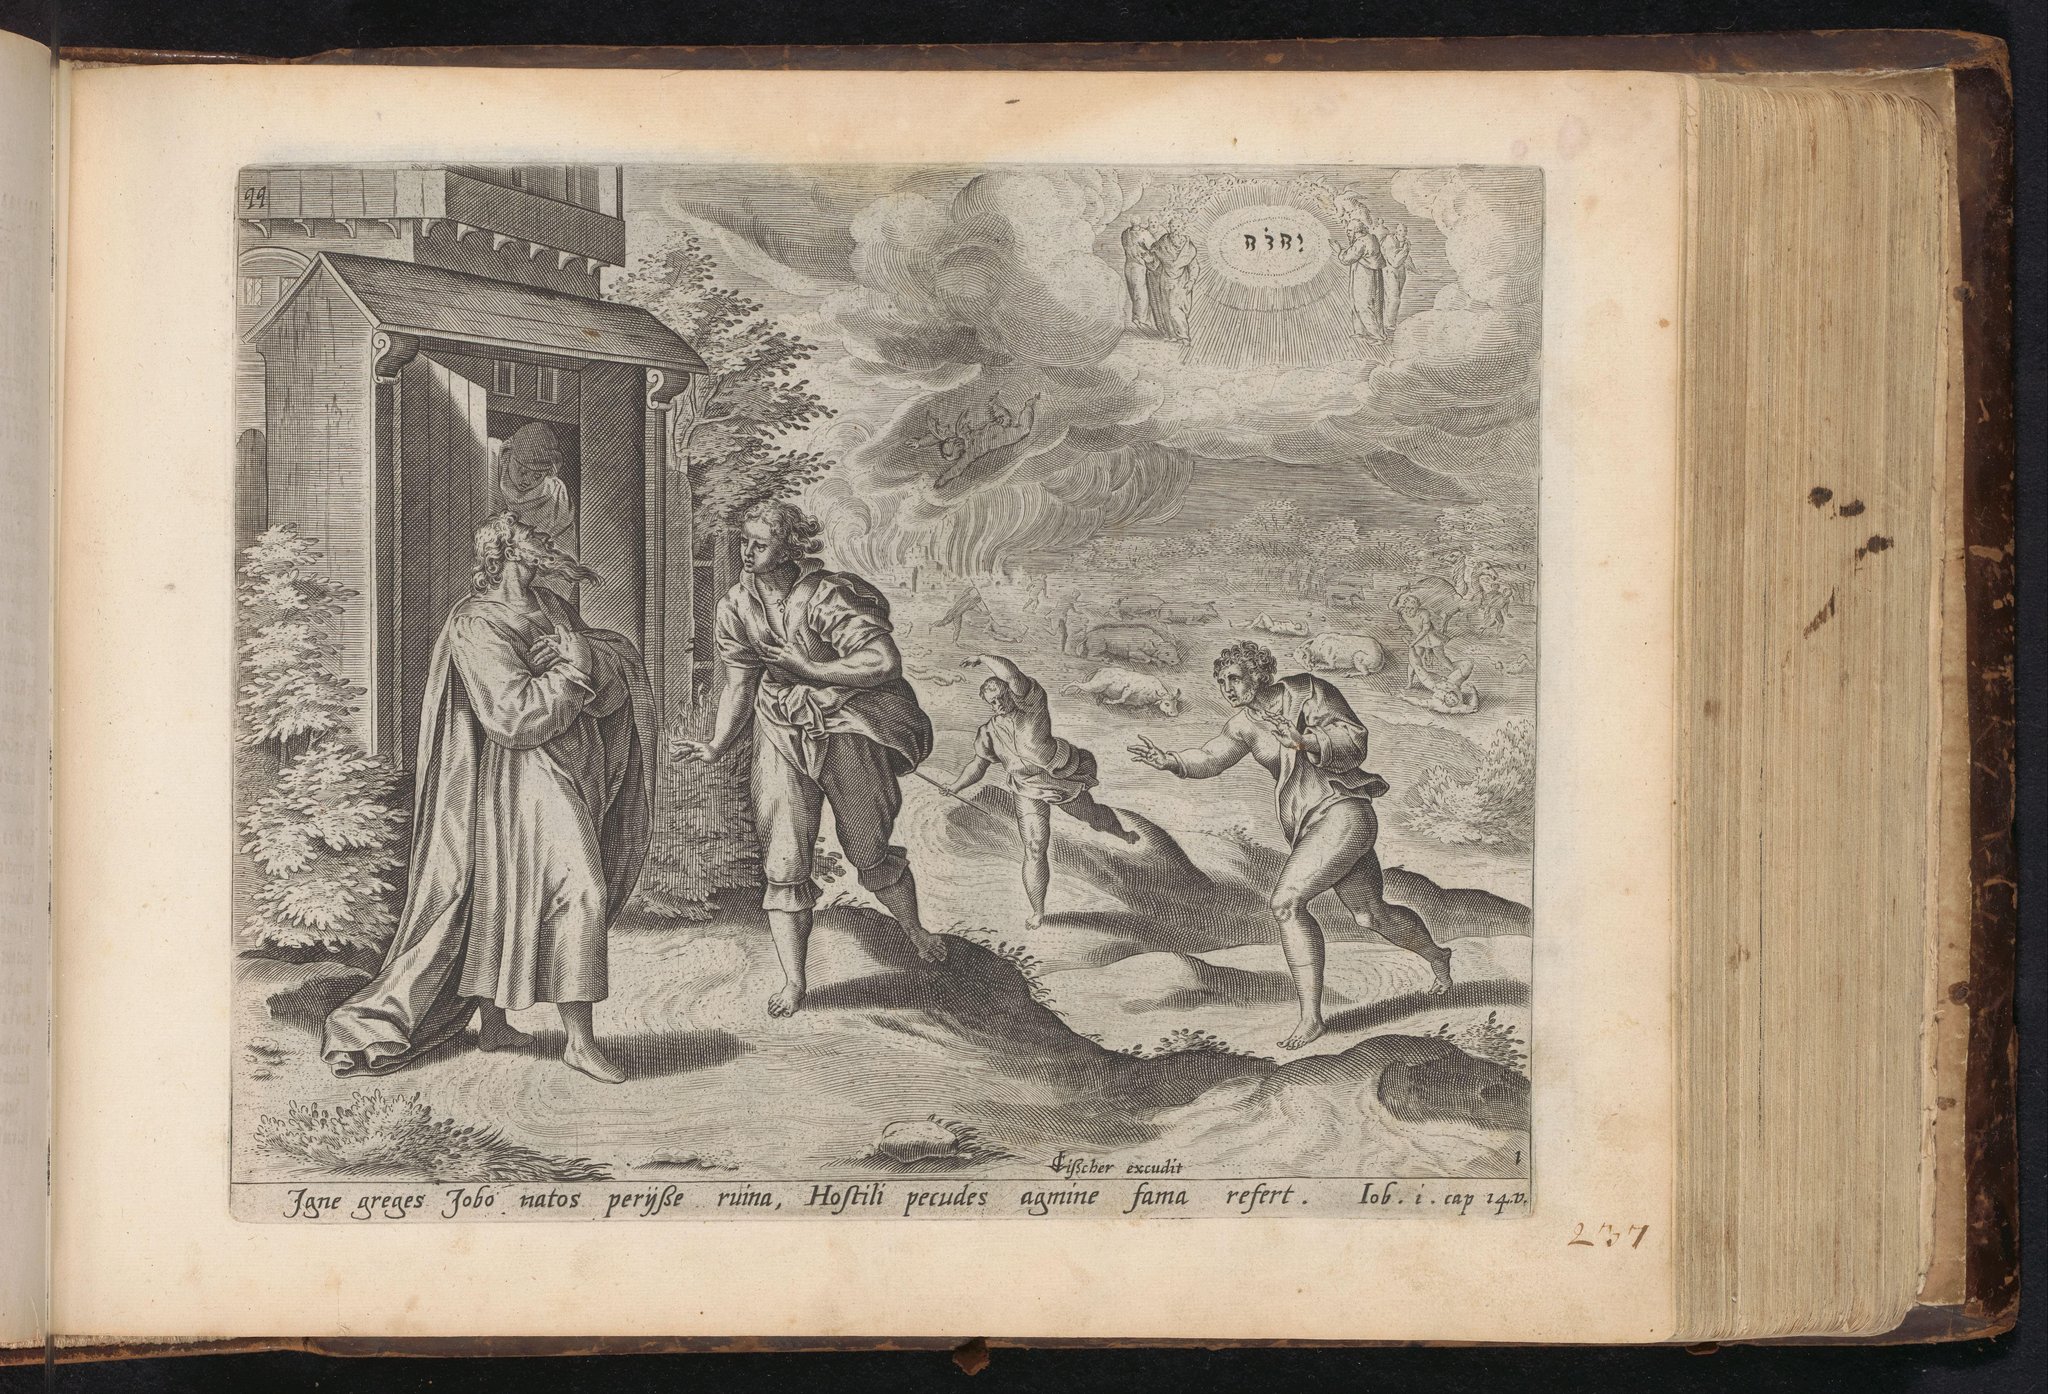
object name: print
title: Job hoort het slechte nieuws van boodschappers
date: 1579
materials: paper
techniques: engraving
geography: amsterdam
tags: the 'sons of god' (angels) with satan gather before god (job 1:6-12), messengers present themselves to job, each reporting a new disaster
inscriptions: number: ‘237’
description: Job hoort van drie boodschappers over het onheil dat hem is overkomen. In de deuropening staat zijn vrouw, die haar zakdoek voor haar gezicht houdt. In het landschap is te zien hoe Jobs vee en kamelen worden gestolen, hoe zijn herders en vee zijn omgekomen door de bliksem en hoe het huis in de stad links, waarin de kinderen van Job een feest hielden, instort in de storm. Aan de hemel het tetragram, als symbool van God de Vader en de hemelbewoners die hun opwachting maken. Onder de voorstelling een verwijzing in het Latijn naar de Bijbeltekst in Job 1:14. Deze prent maakt deel uit van een album.